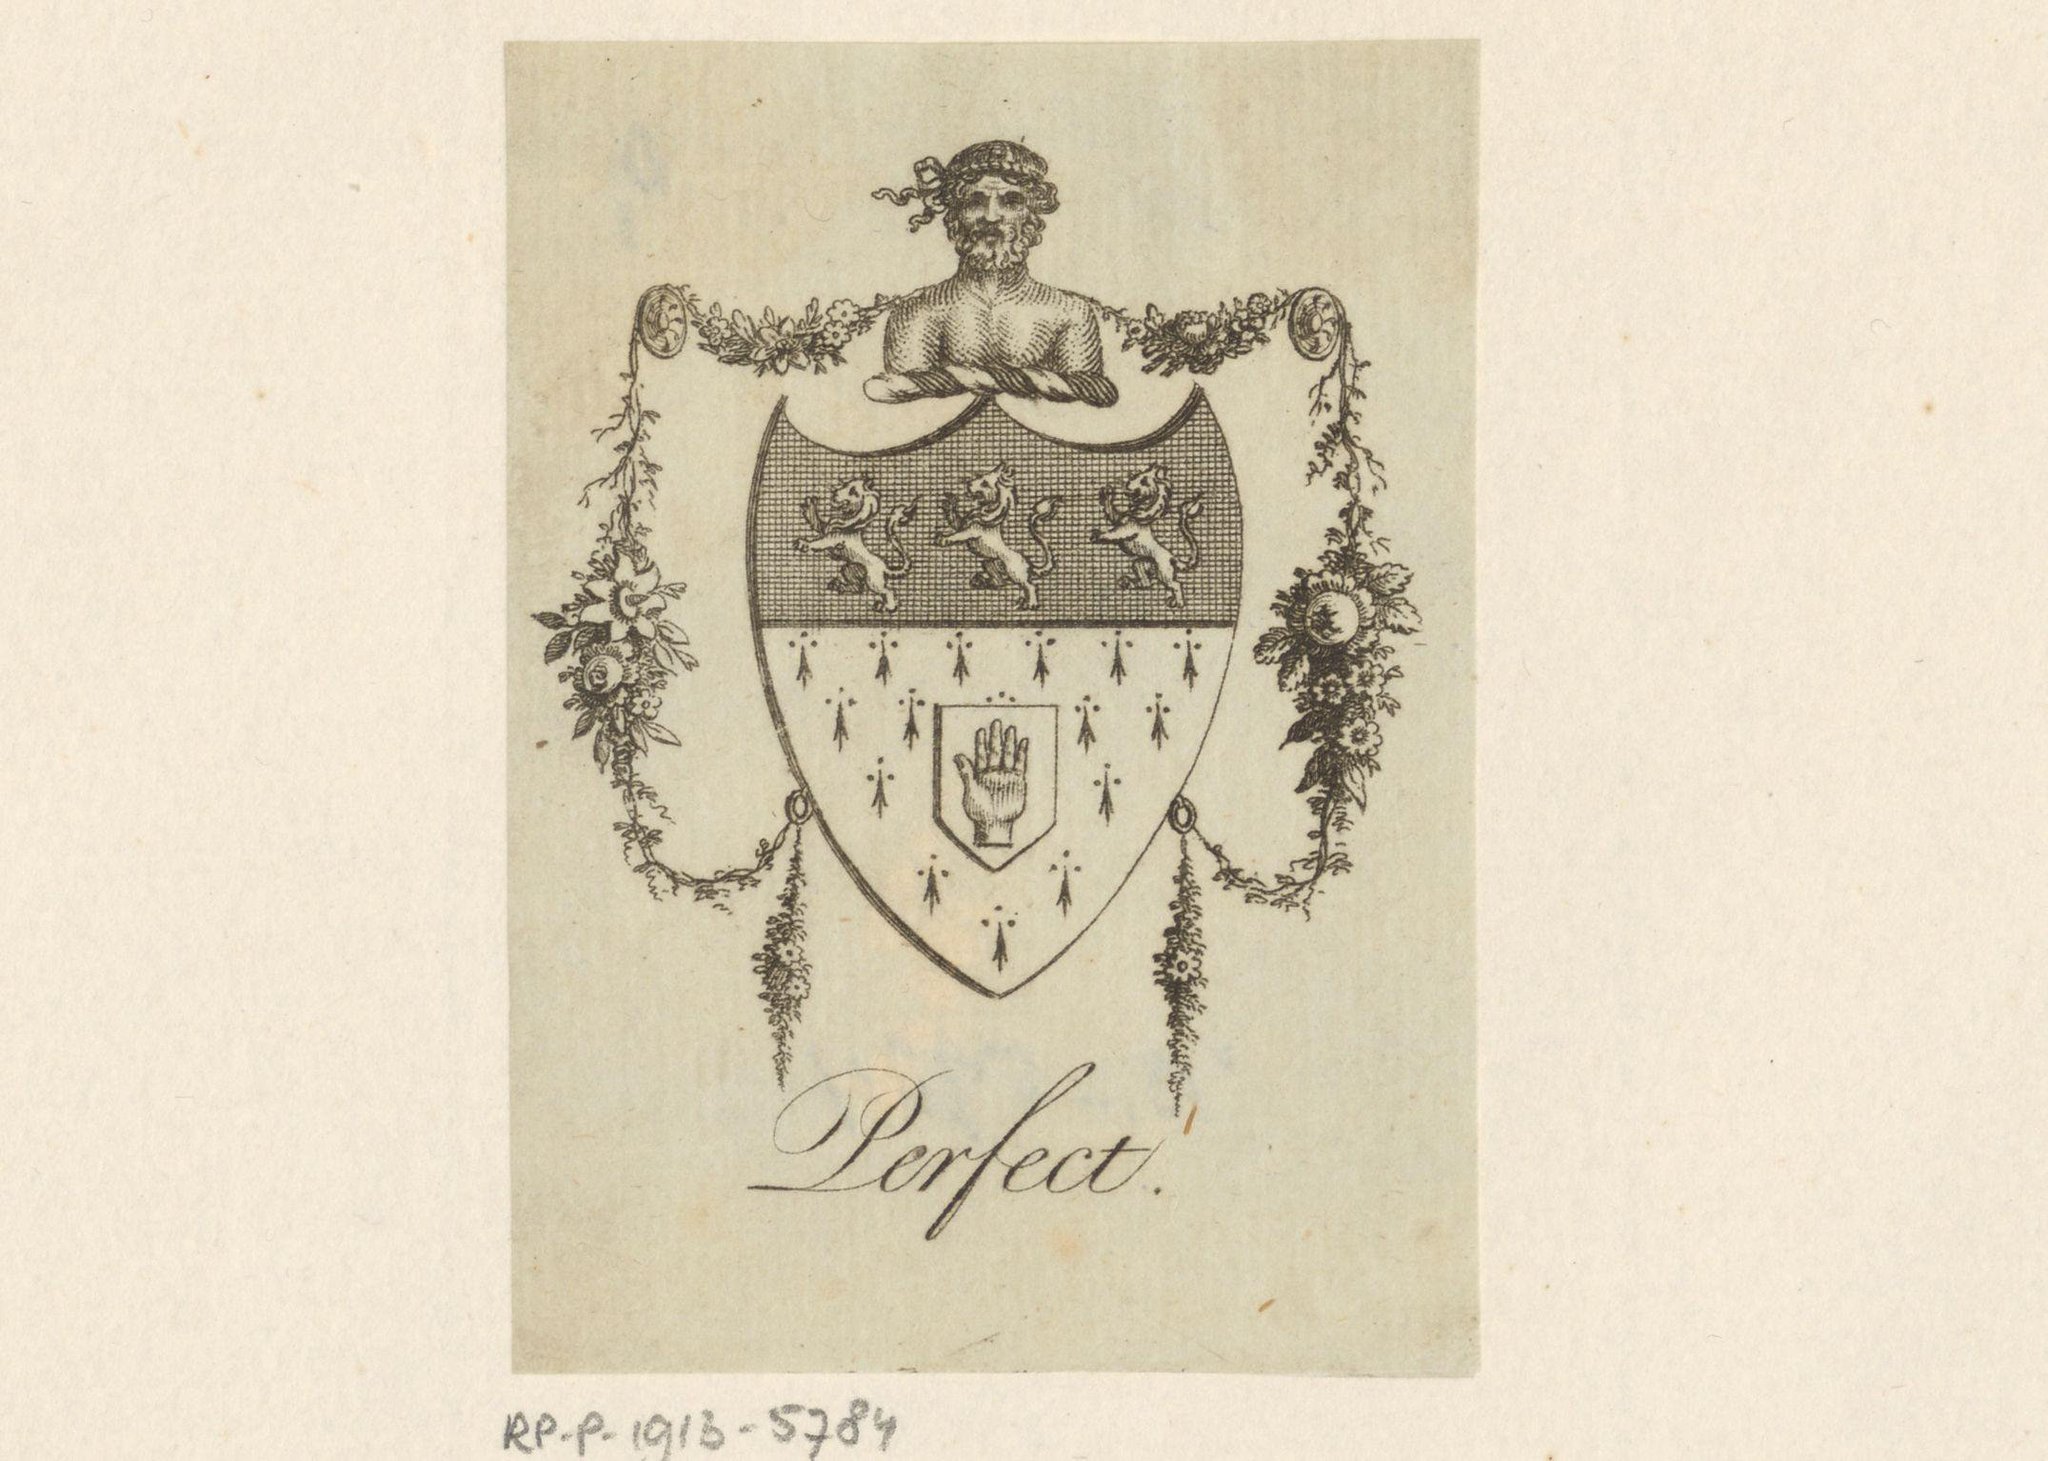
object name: bookplate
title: Ex libris van Perfect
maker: Anonymous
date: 1700-1900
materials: paper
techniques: etching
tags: chest, bust, ornament ~ festoon, garland, armorial bearing, heraldry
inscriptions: collector's mark: Lugt 2233, collector's mark: Lugt 2760